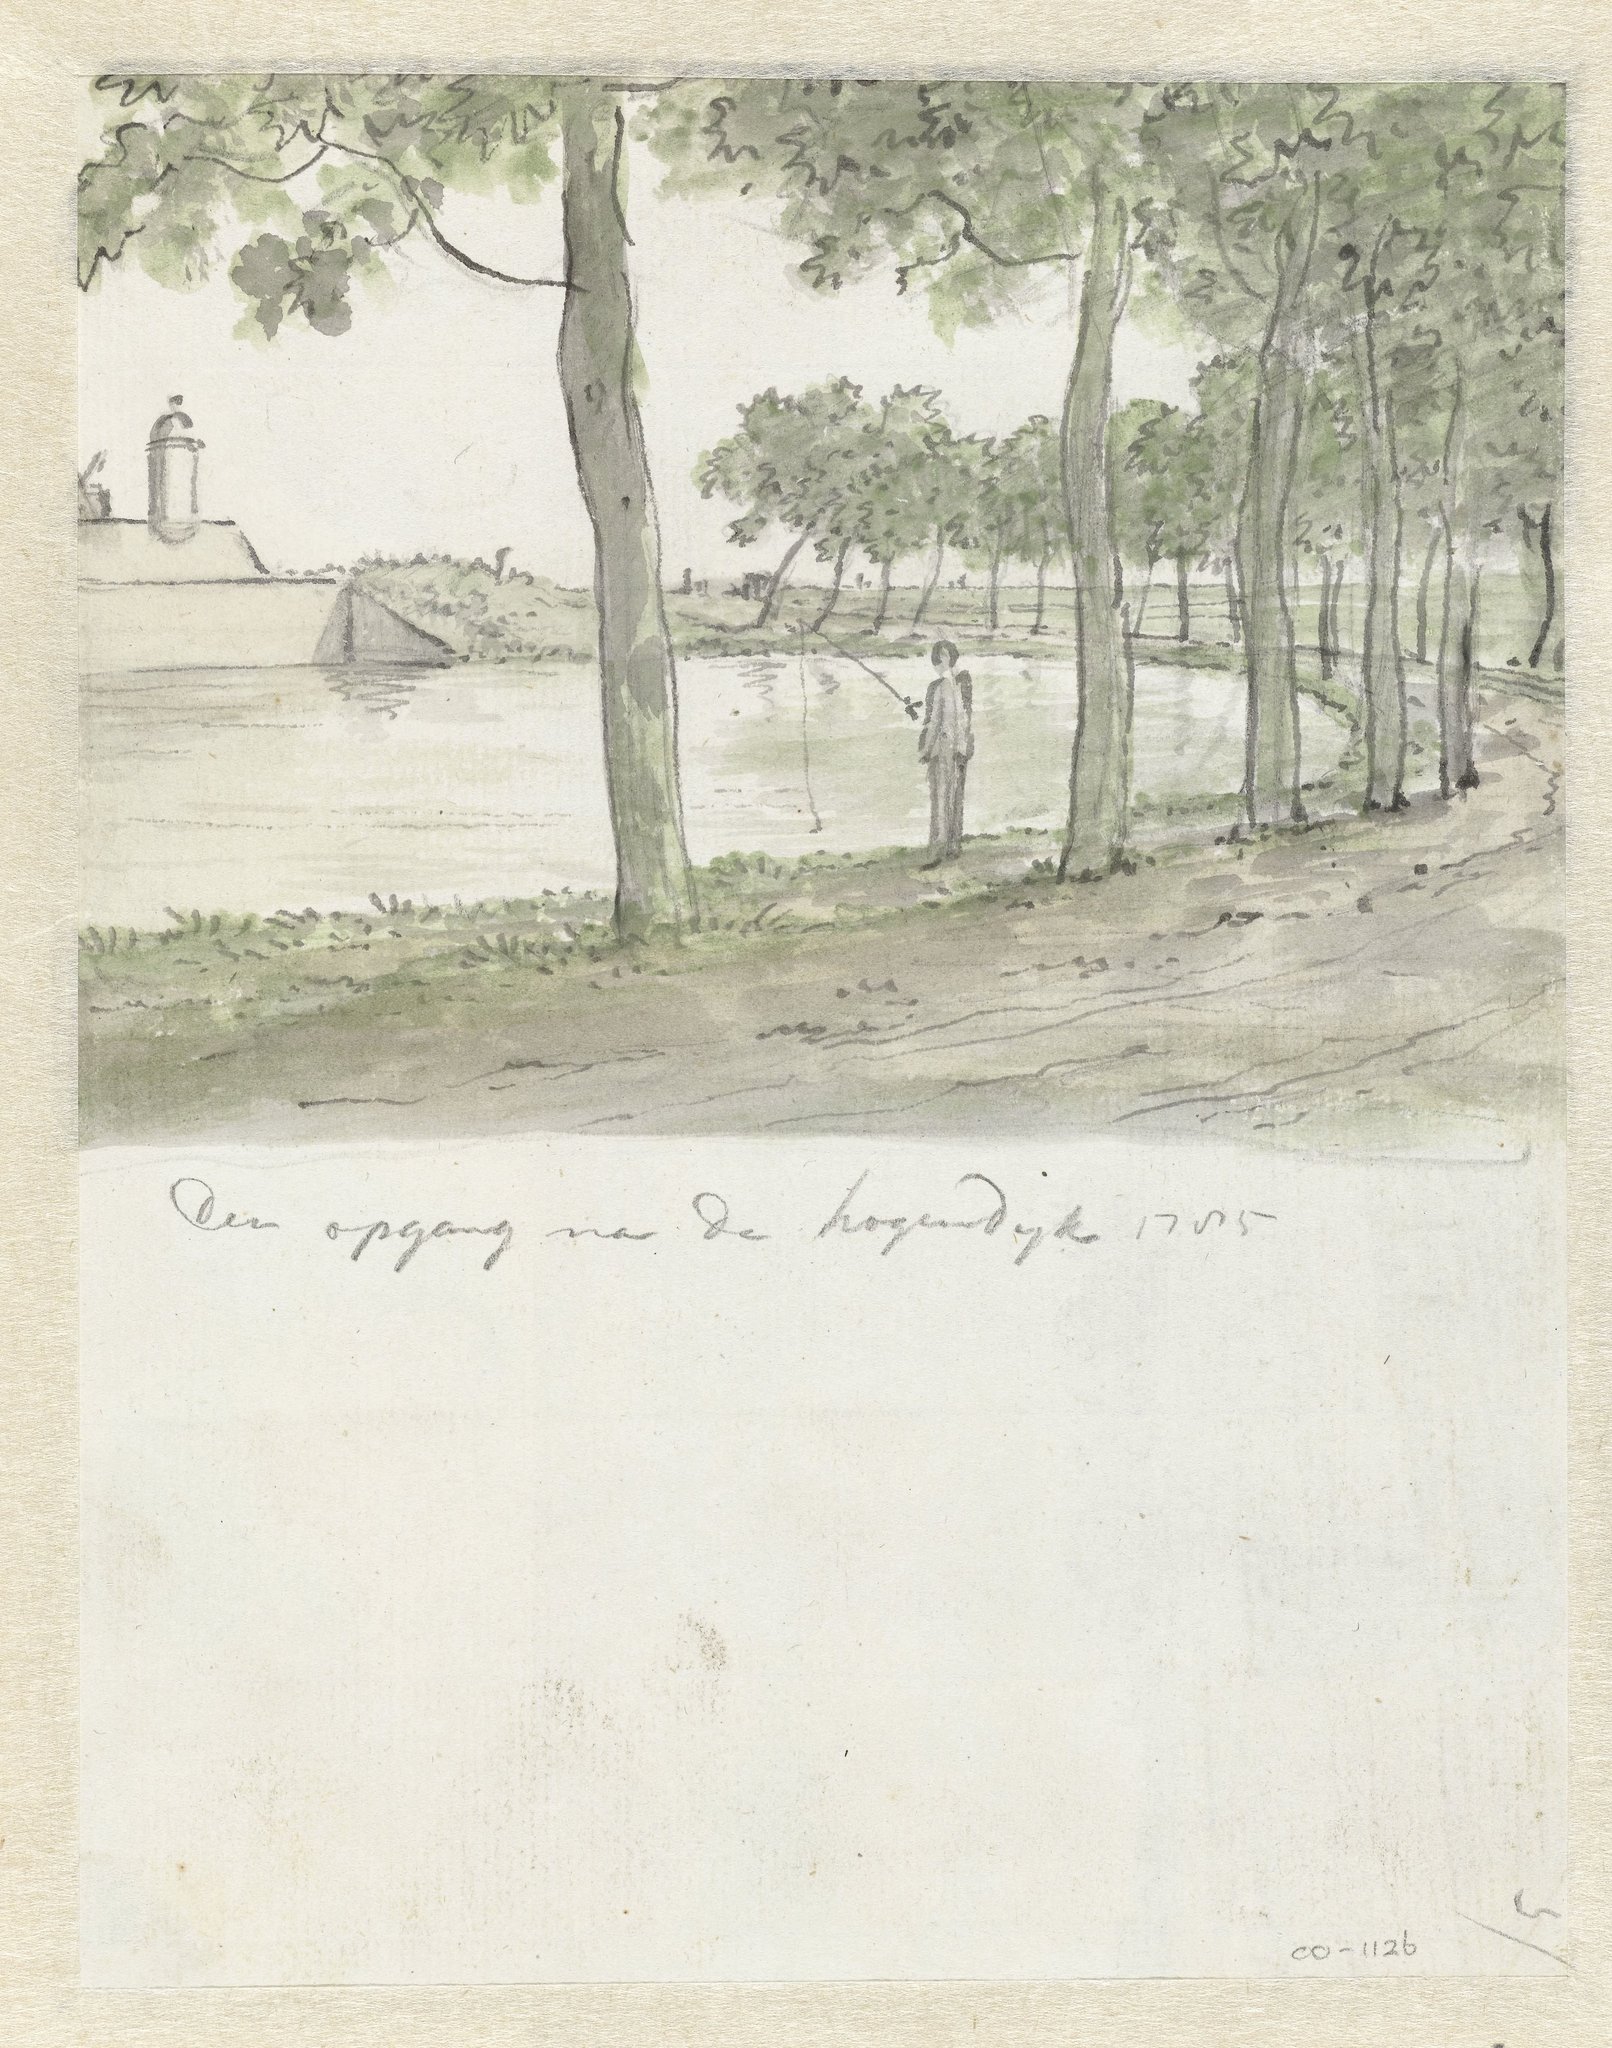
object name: watercolor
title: De opgang naar de Hogendijk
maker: jurriaan andriessen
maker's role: draughtsman, painter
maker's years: 1742-1819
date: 1785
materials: ink, paper, pencil, watercolor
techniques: brush, pen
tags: dikes, levee